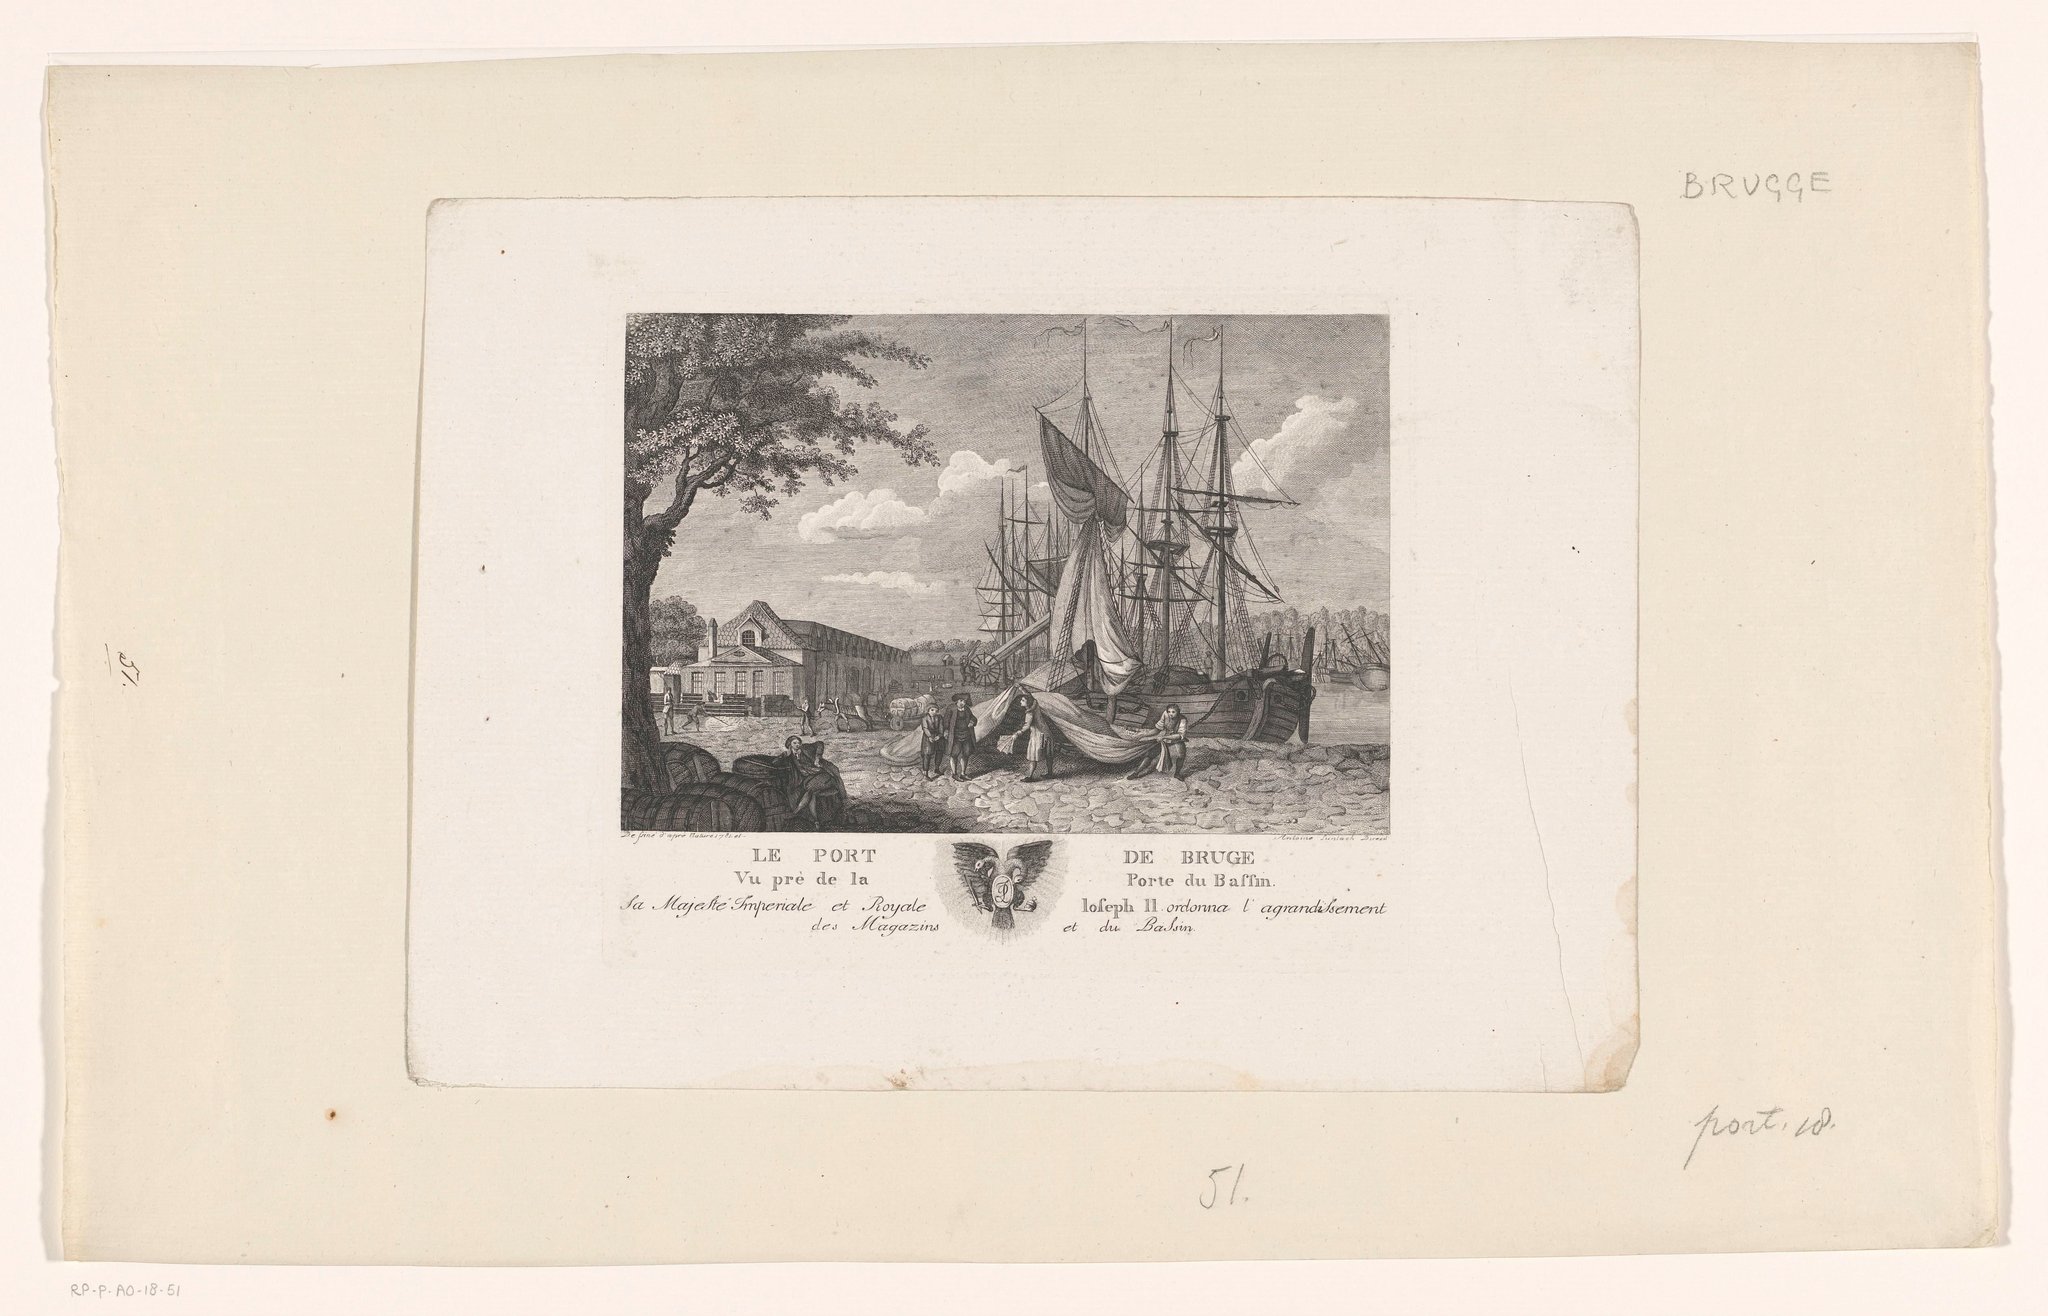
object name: print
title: Gezicht op de haven van Brugge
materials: paper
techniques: etching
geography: venice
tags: harbour, sailing-ship, sailing-boat, bruges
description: Gezicht op de haven van Brugge, in de situatie omstreeks 1781. Op de voorgrond figuren die bezig zijn met een zeil, daarachter schepen. Onder de prent de titel, met in het midden de adelaar van Keizer Jozef II.